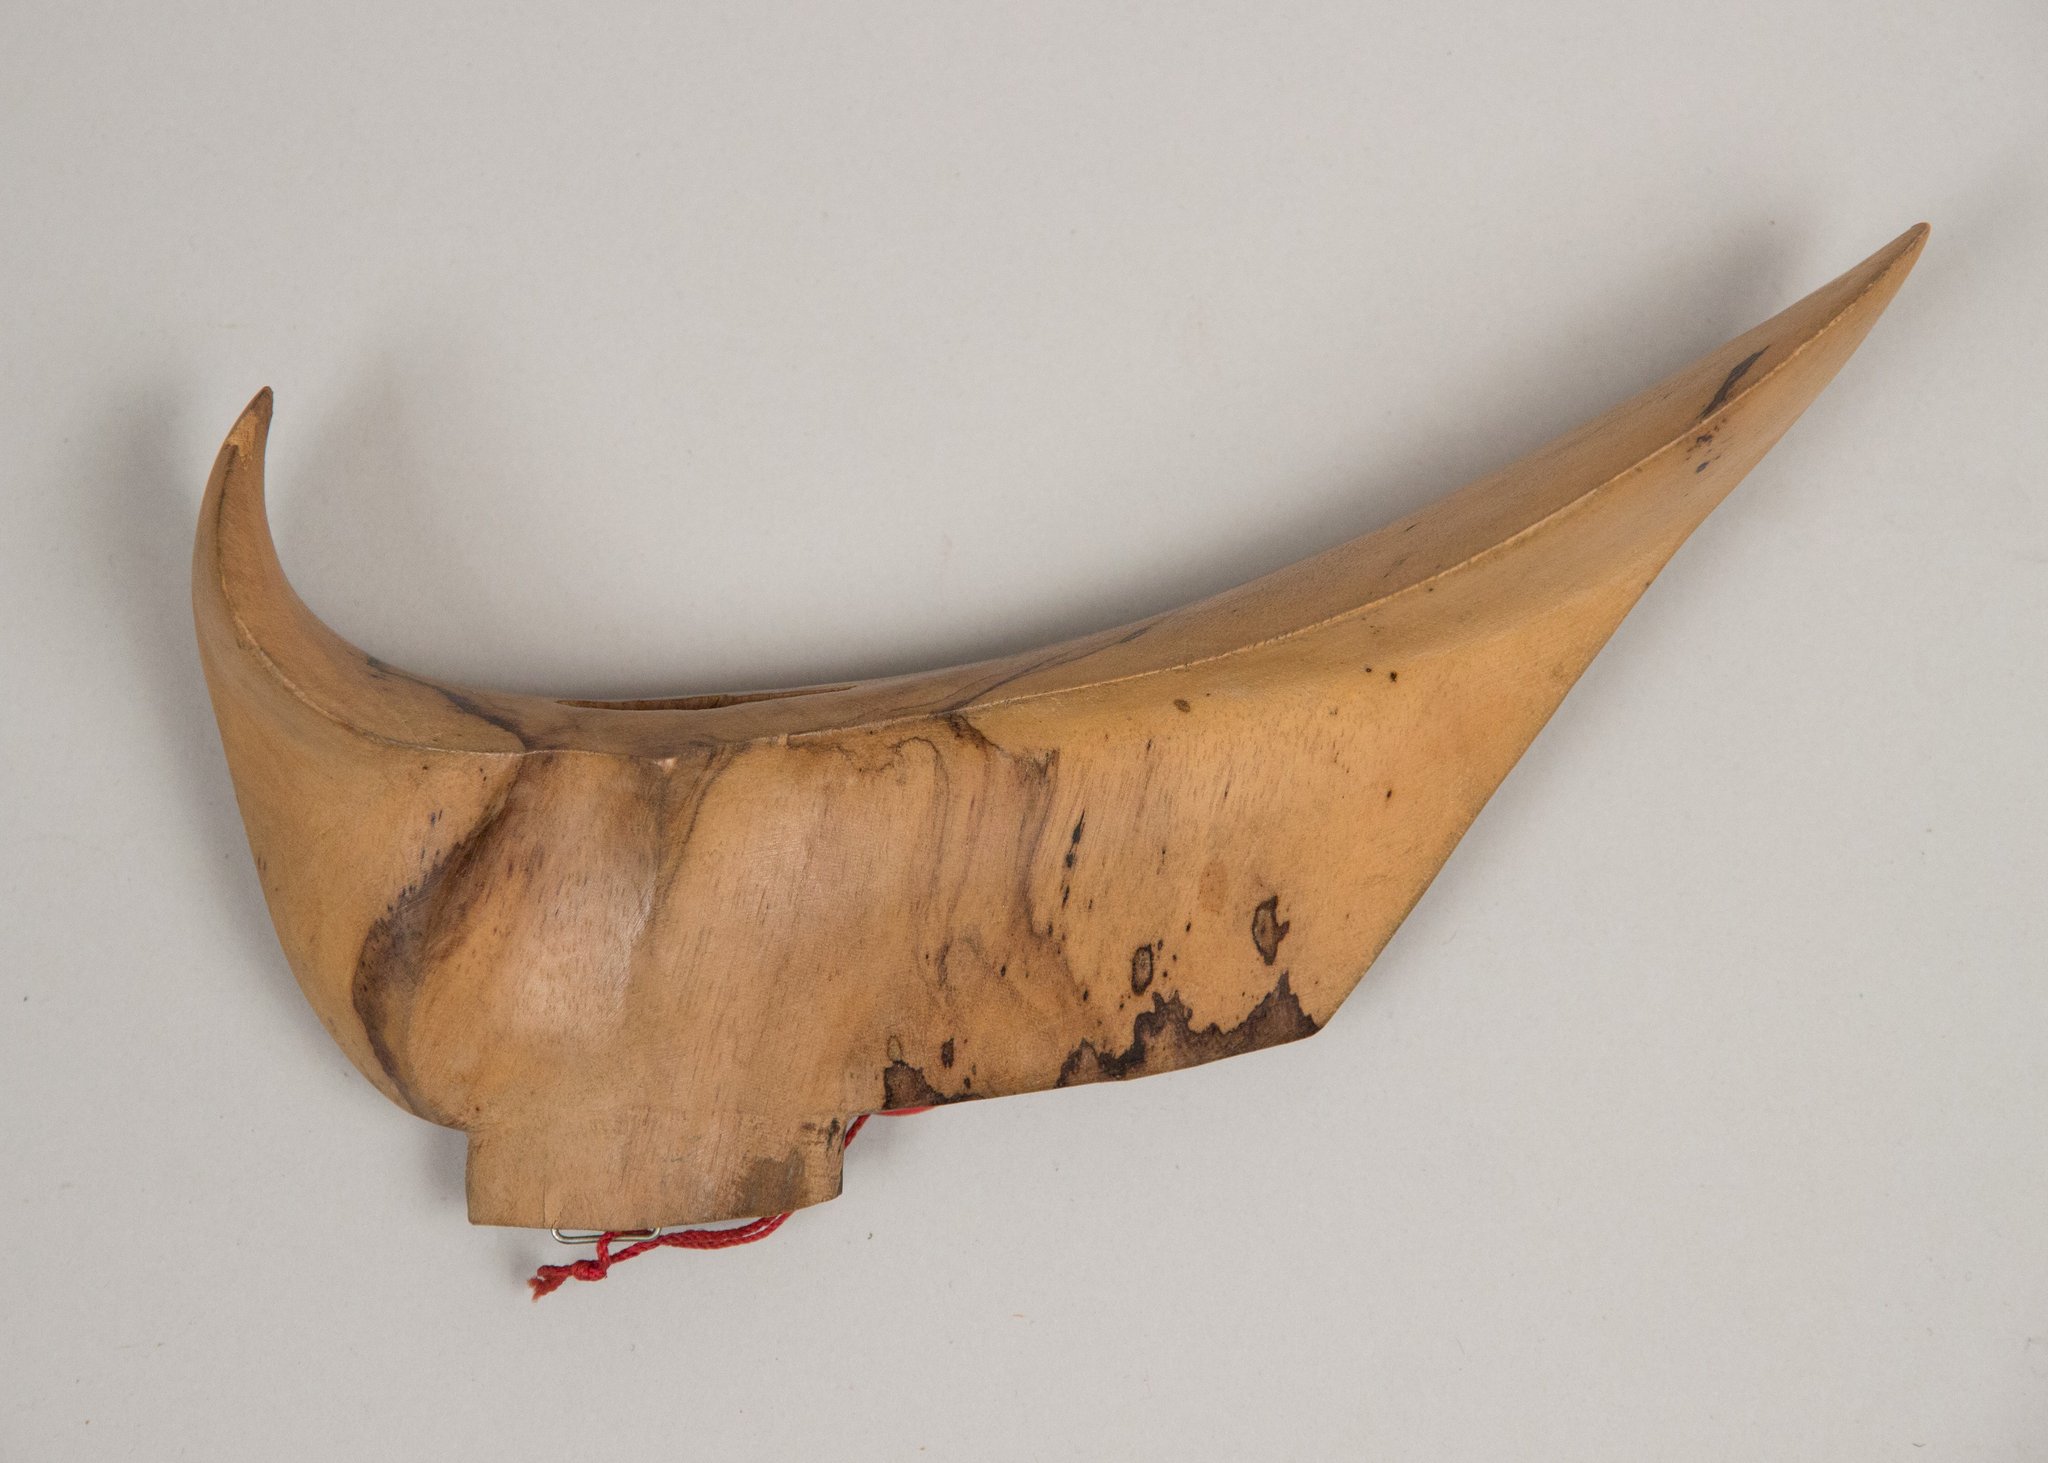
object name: kris sheath part and mount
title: Kris Sheath Parts and Mounts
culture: javanese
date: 1501-1900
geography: indonesia